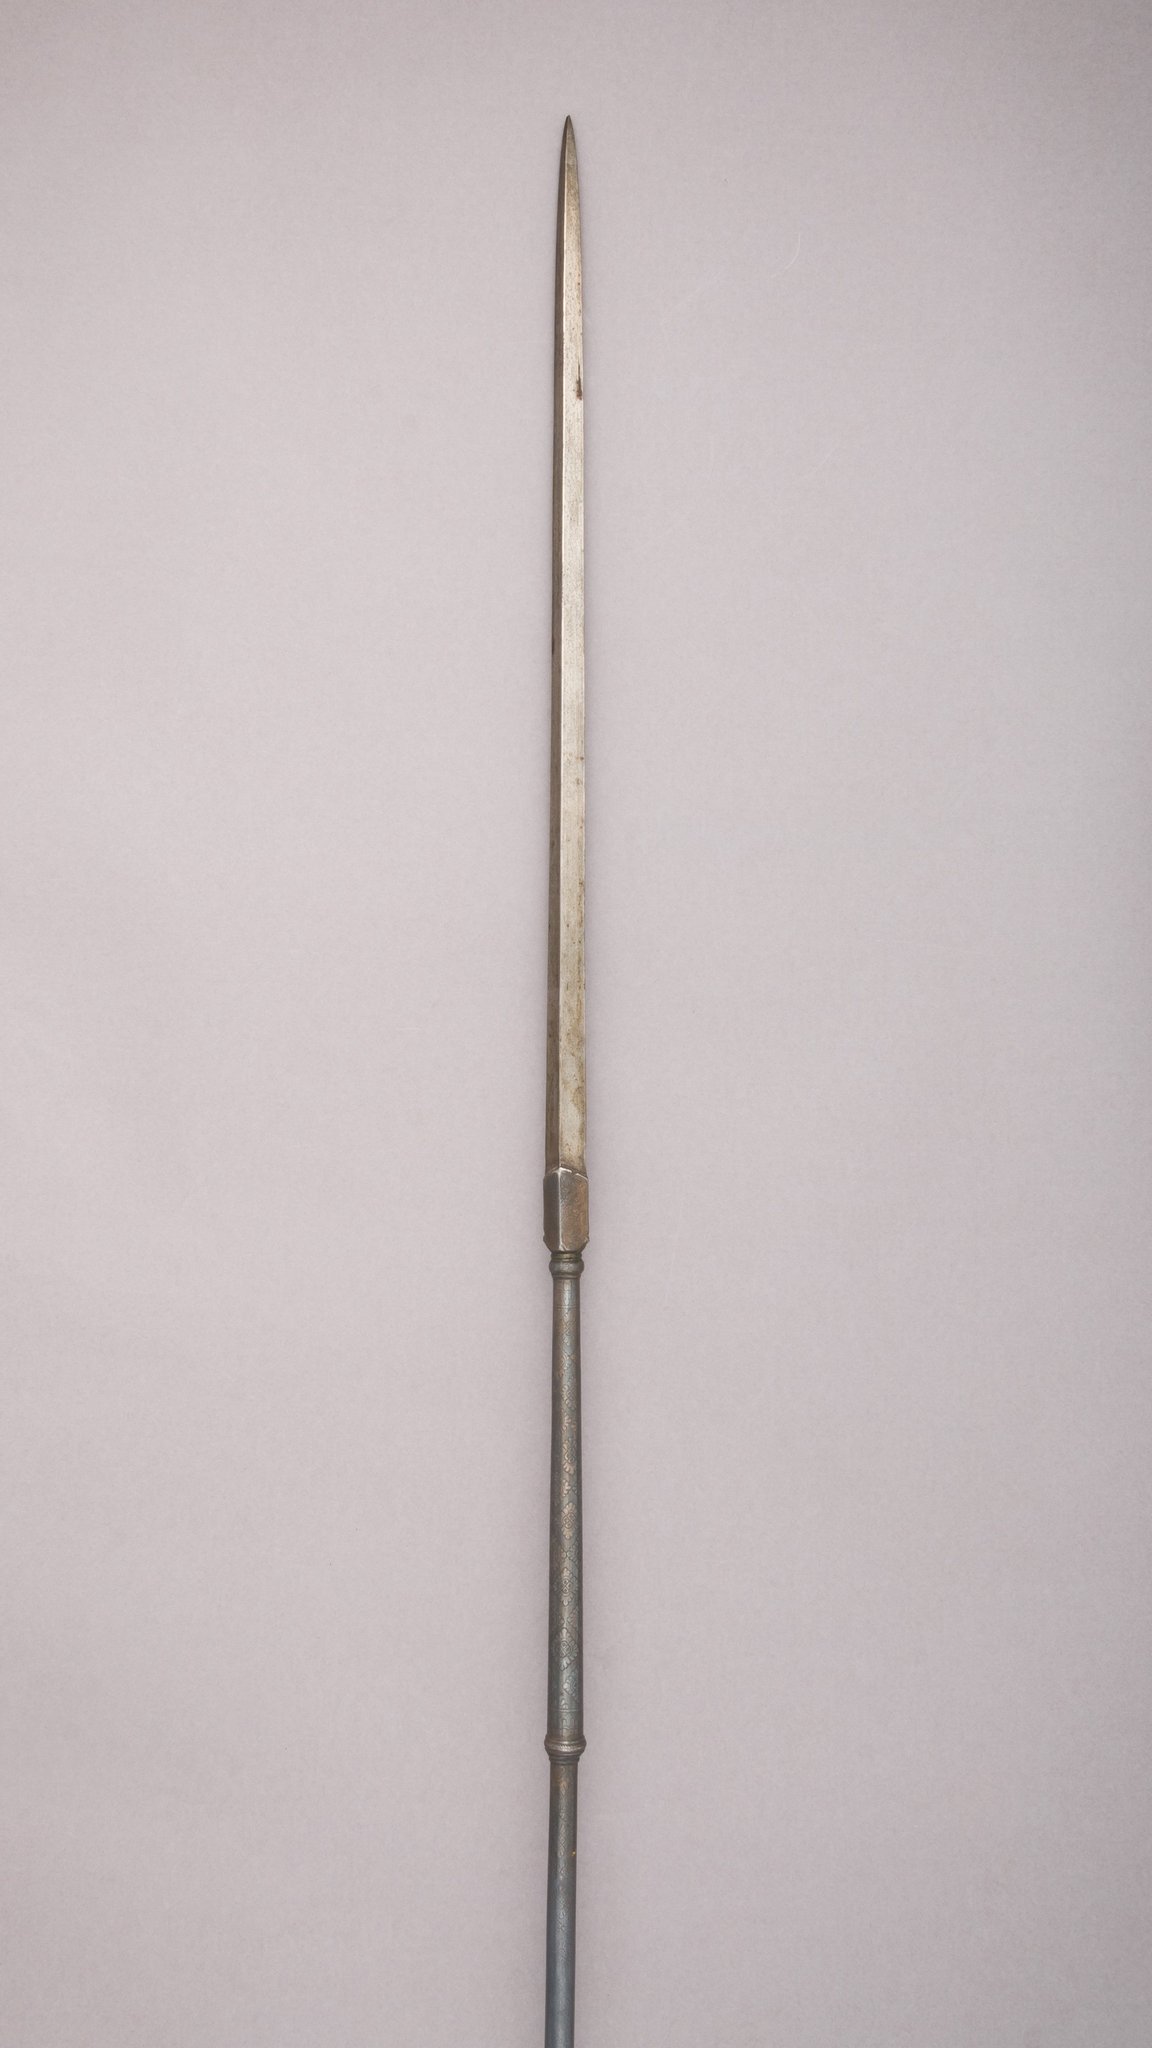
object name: spear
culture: indian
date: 1701-1900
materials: gold, silver, steel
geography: india